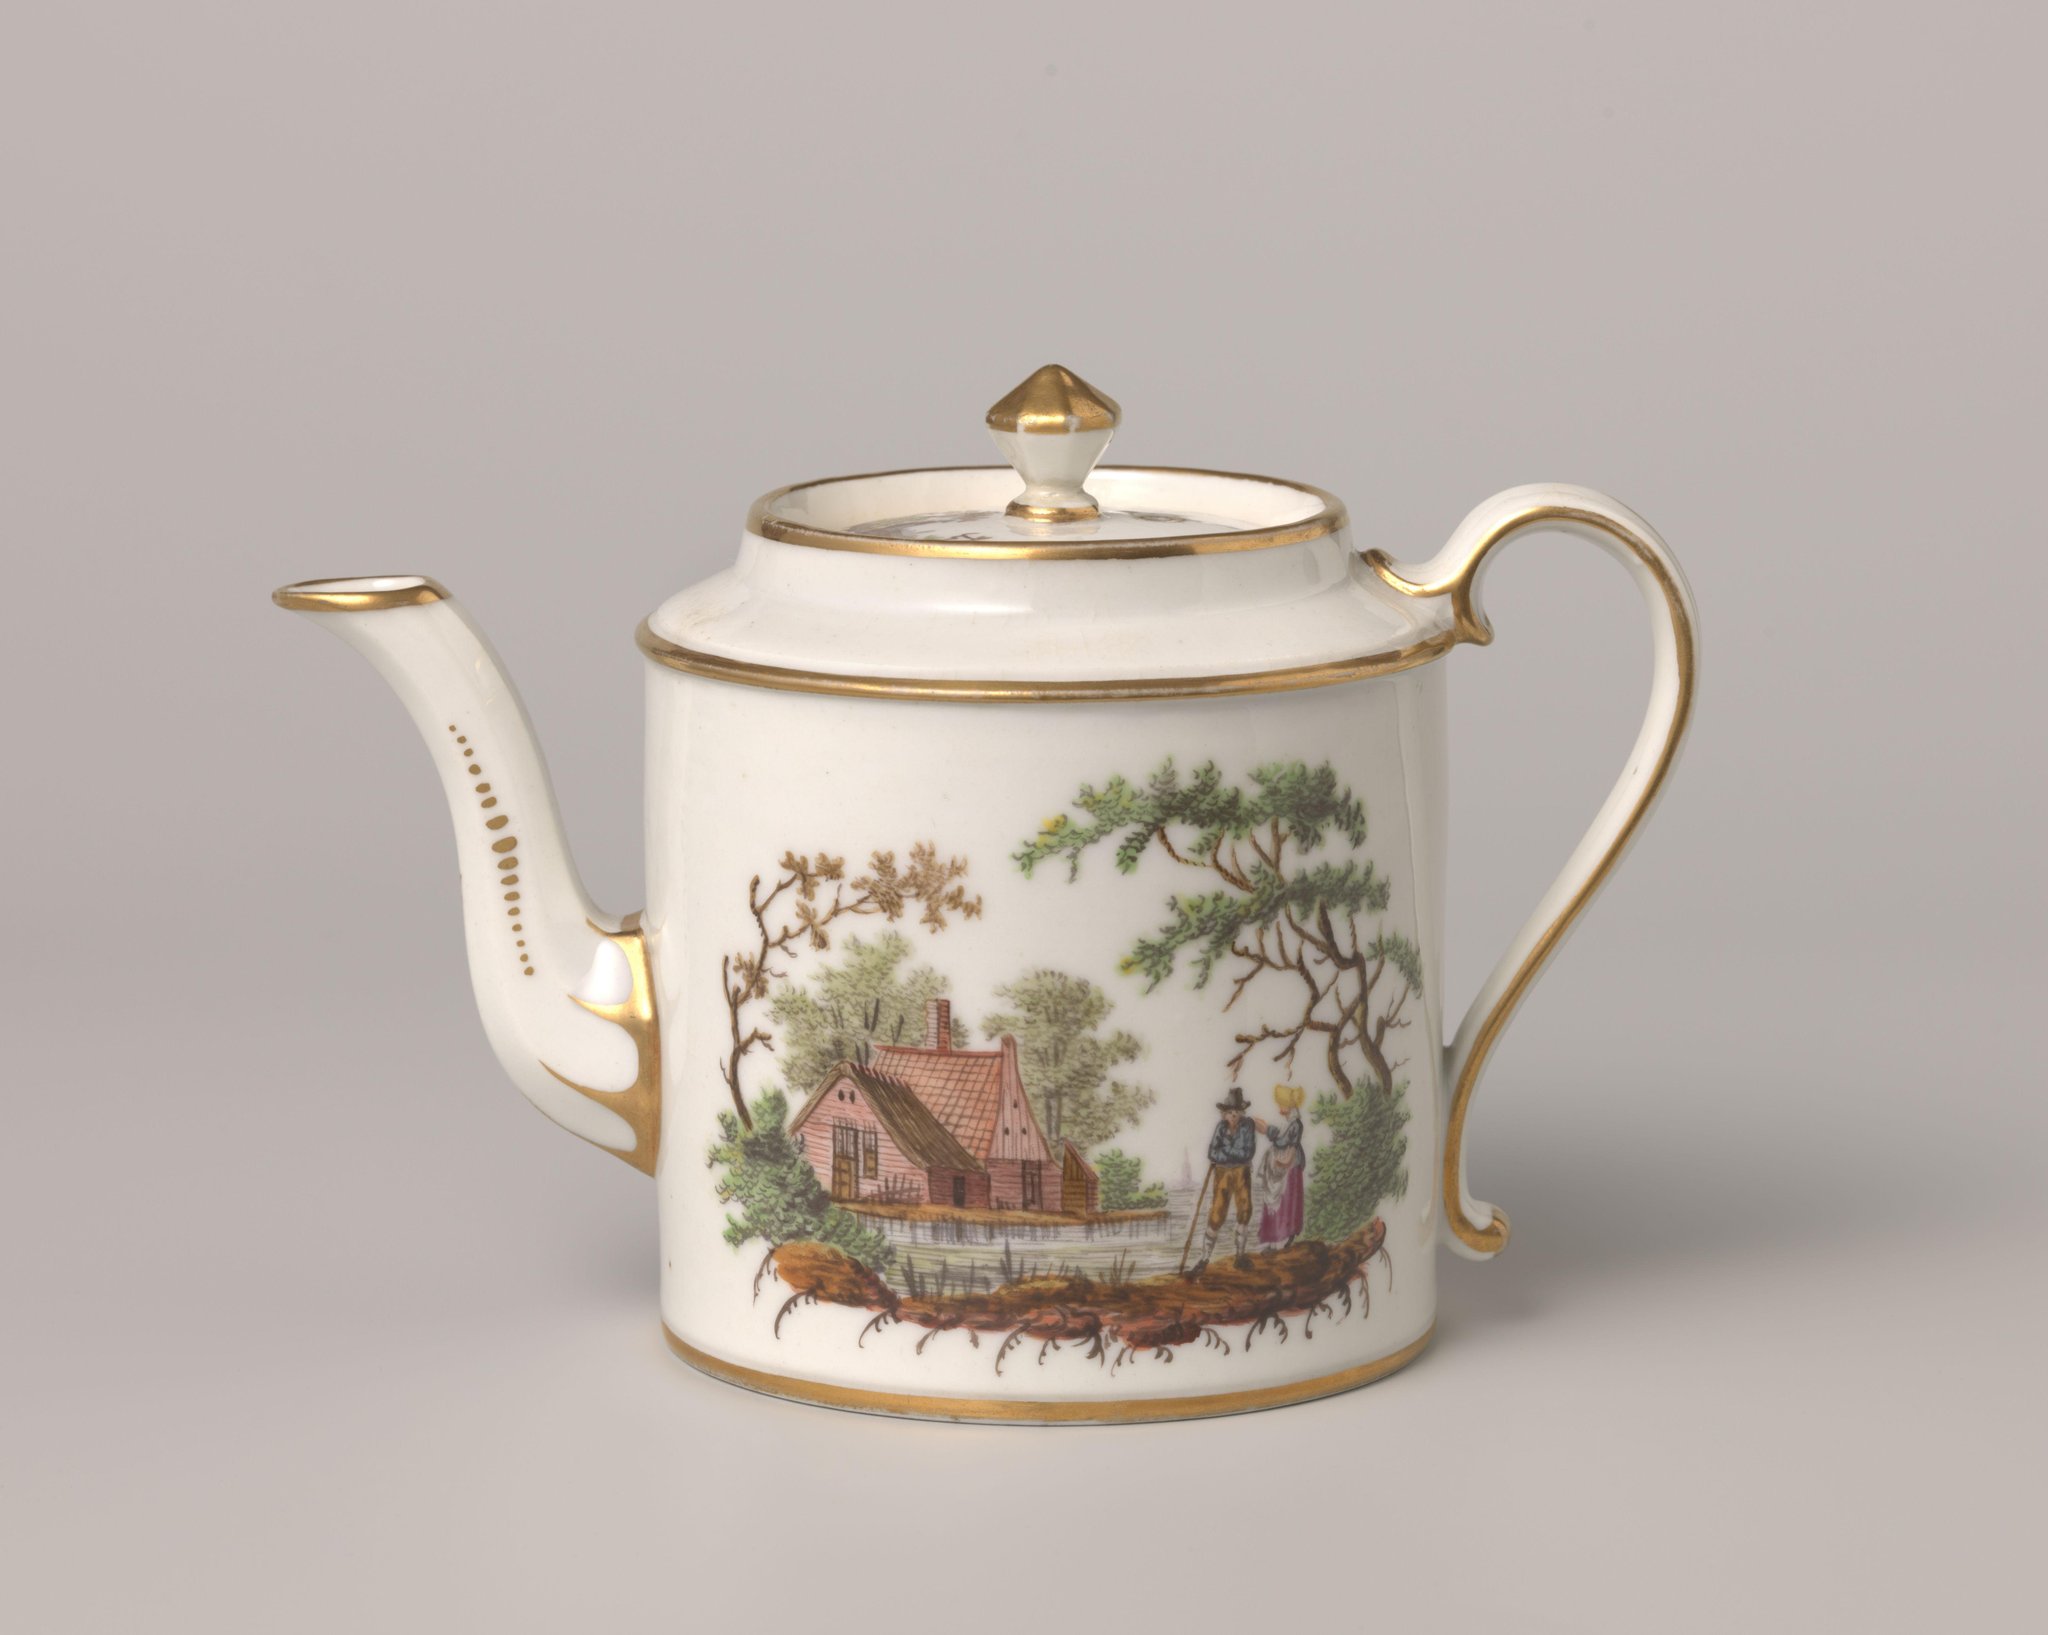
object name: teapot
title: Theepot, beschilderd met een landschap met huizen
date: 1809-1814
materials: porcelain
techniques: painted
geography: nieuwer-amstel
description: Theepot van porselein, beschilderd met een landschap met huizen. Gemerkt in zwart: Amstel.